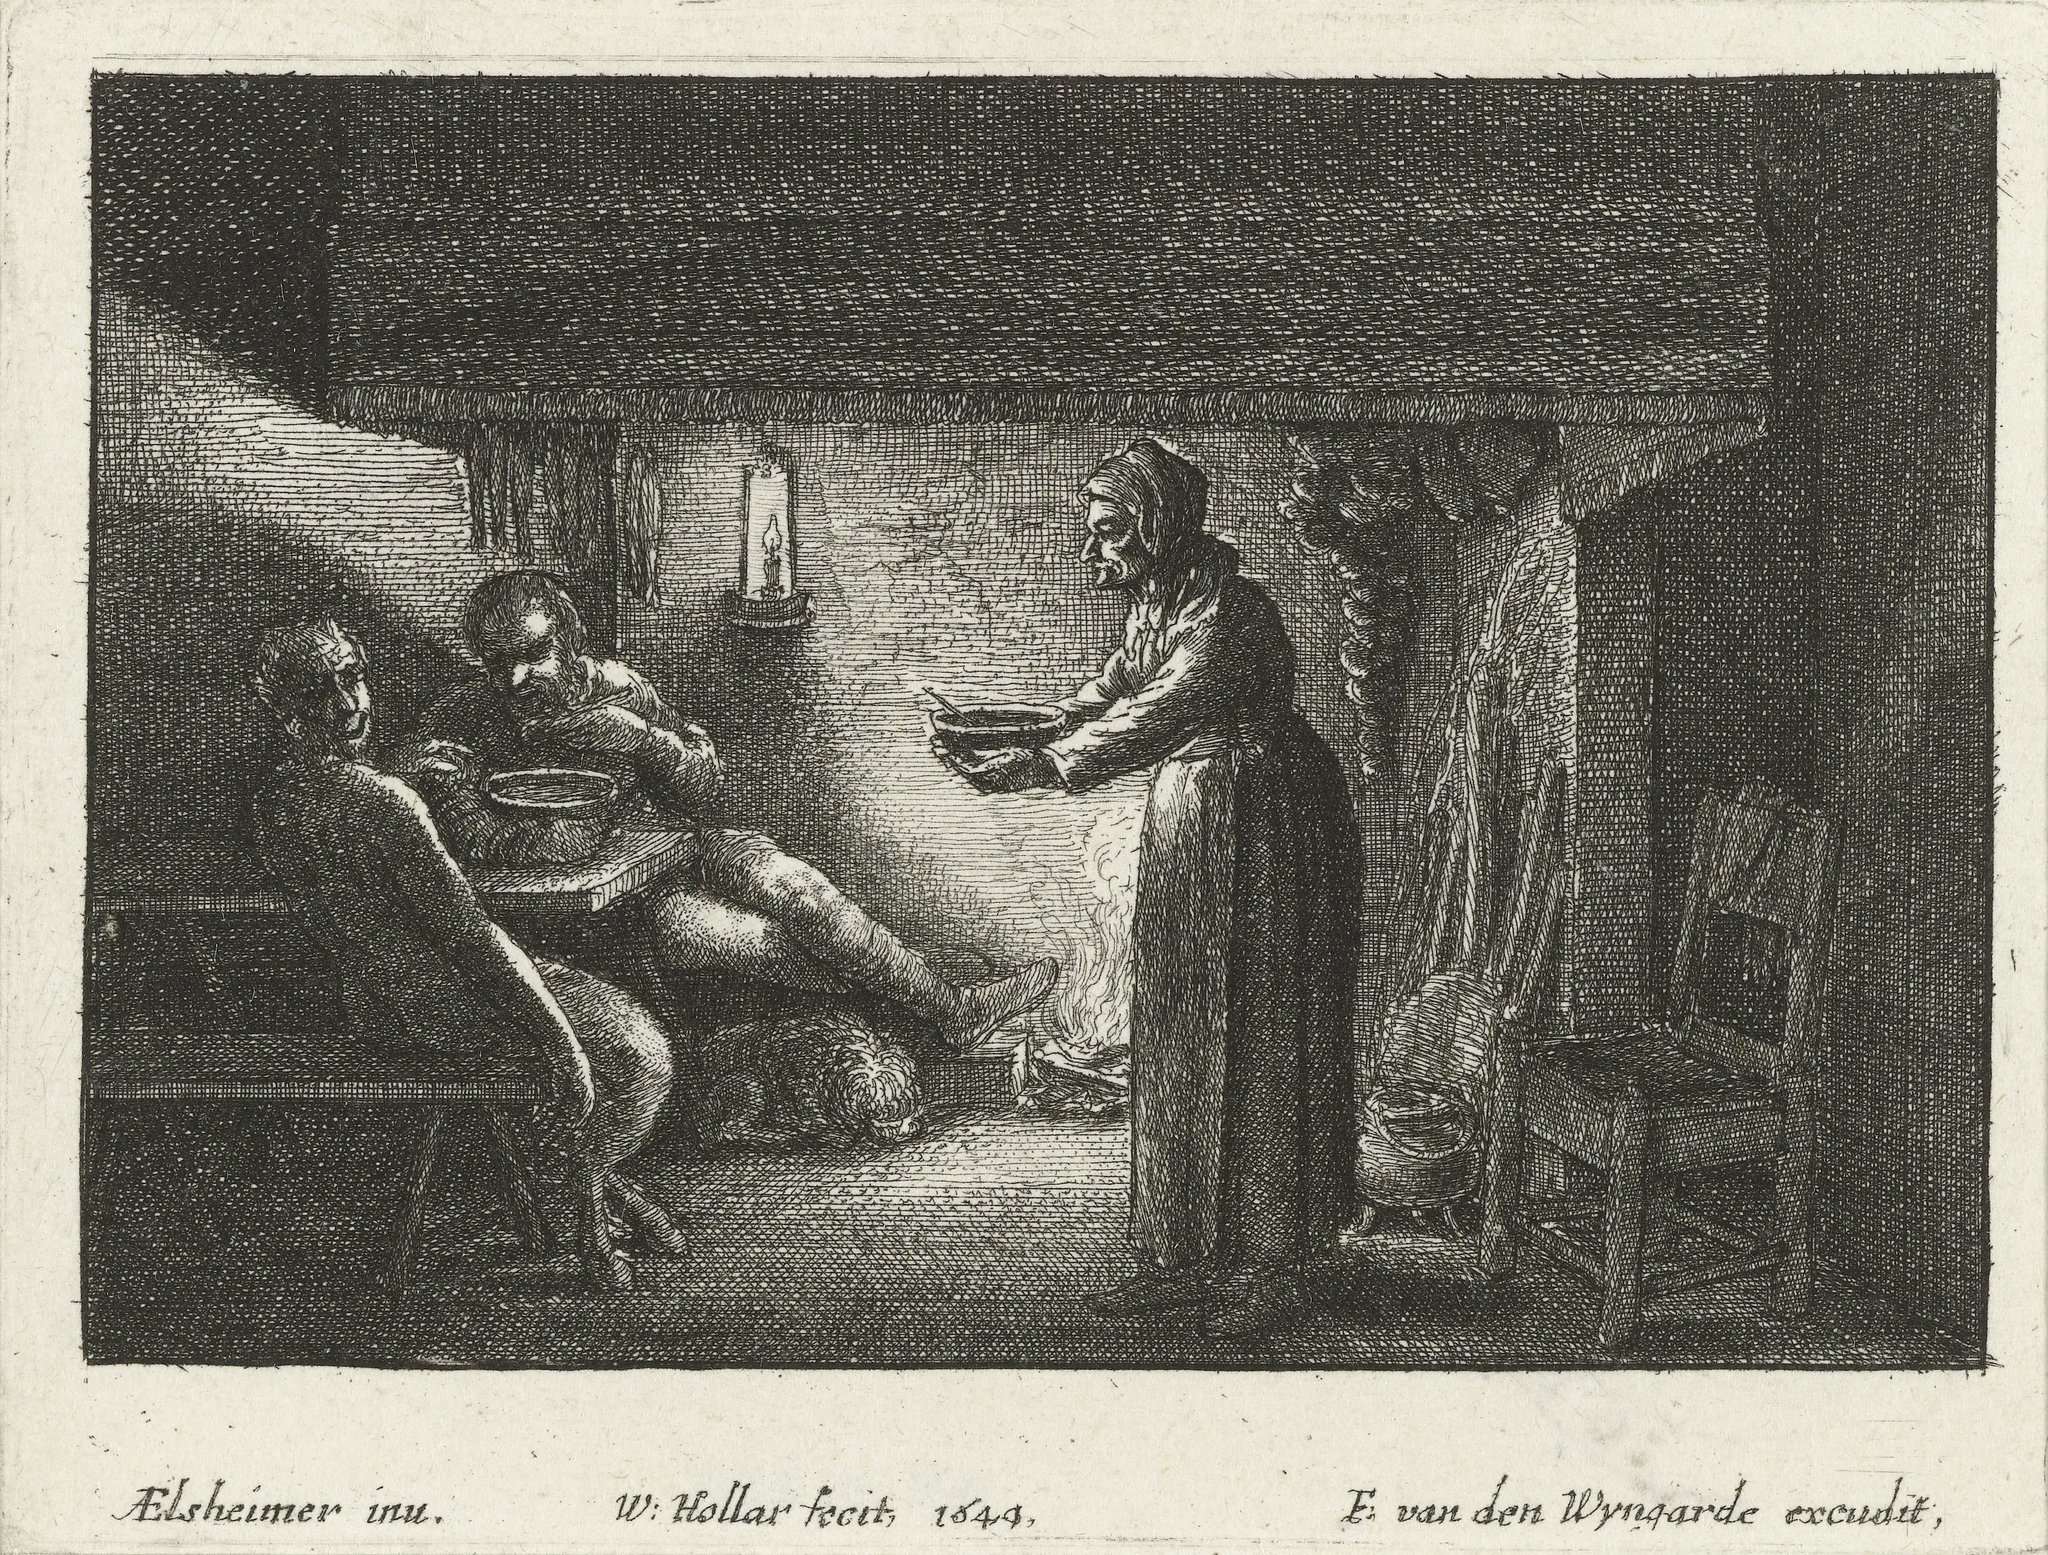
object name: print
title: Fabel van de sater en de boer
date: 1644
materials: paper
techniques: etching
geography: antwerp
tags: the satyr and the peasants; according to aesop: the satyrs and the peasant (meal, blowing to cool food, etc.)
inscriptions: collector's mark: Lugt 240